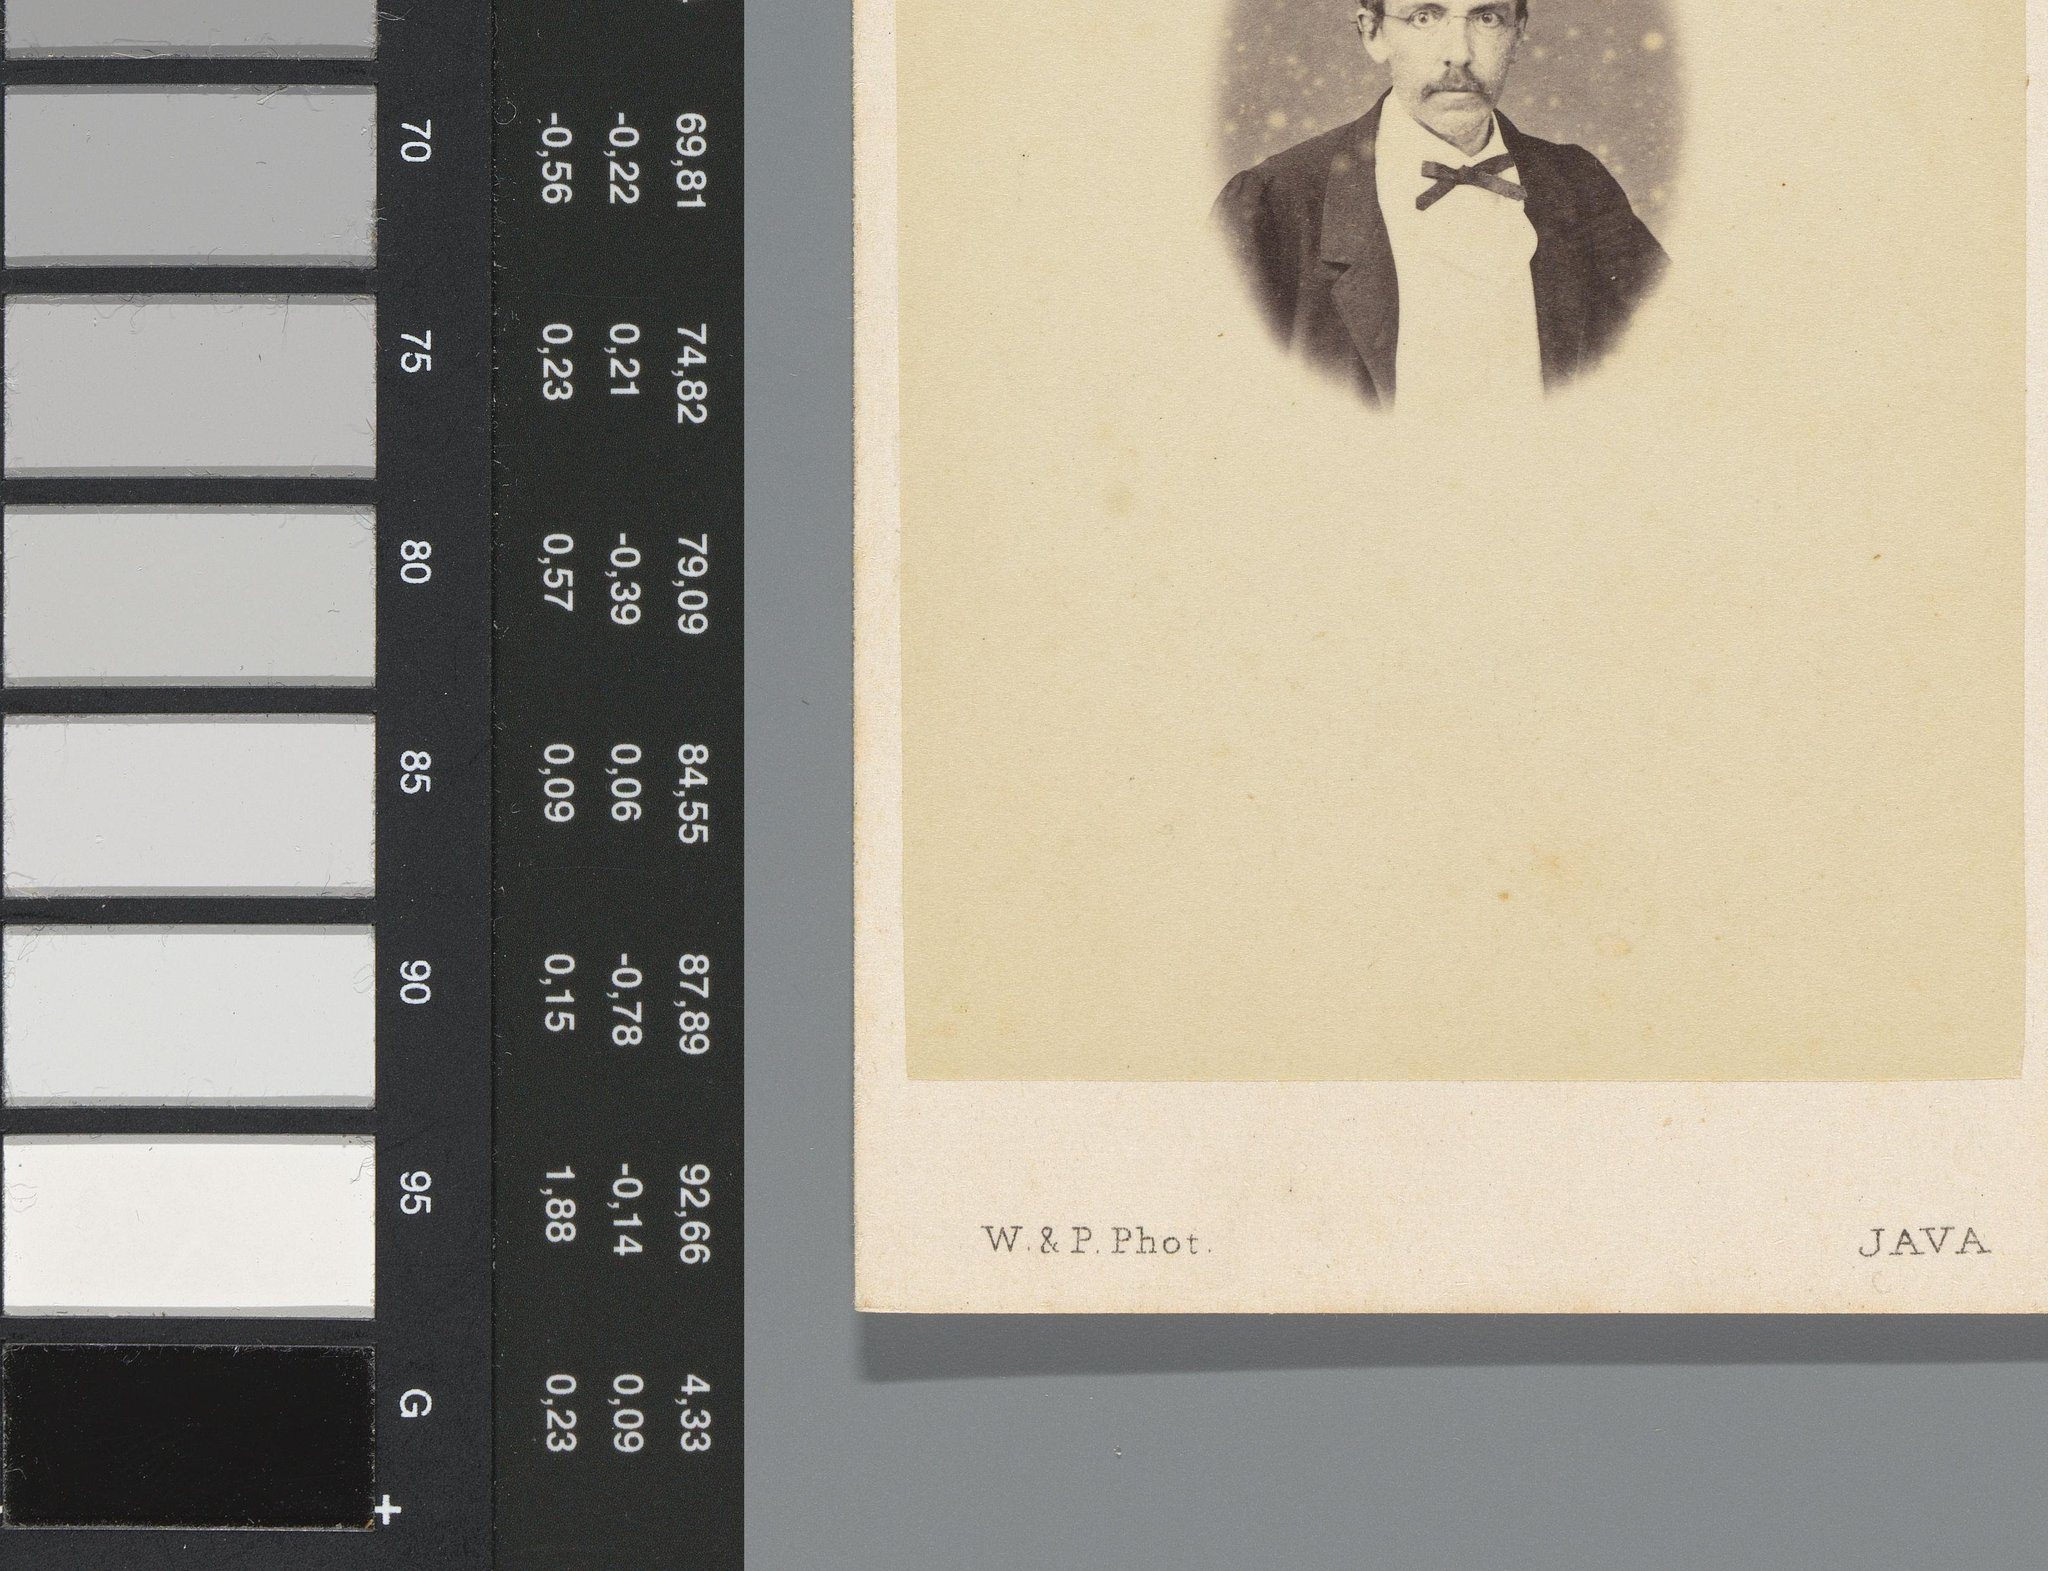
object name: carte de visite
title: Portret van Norbert van den Berg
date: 1855-1910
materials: cardboard, photographic support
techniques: albumen print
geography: java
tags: amsterdam, norbertus petrus van den berg (1831-1917)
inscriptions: name: ‘WOODBURY & PAGE, / PHOTOGRAPHERS / JAVA. .’, name: ‘N.B. van den Berg’, name: ‘W.&P. Phot. Java’